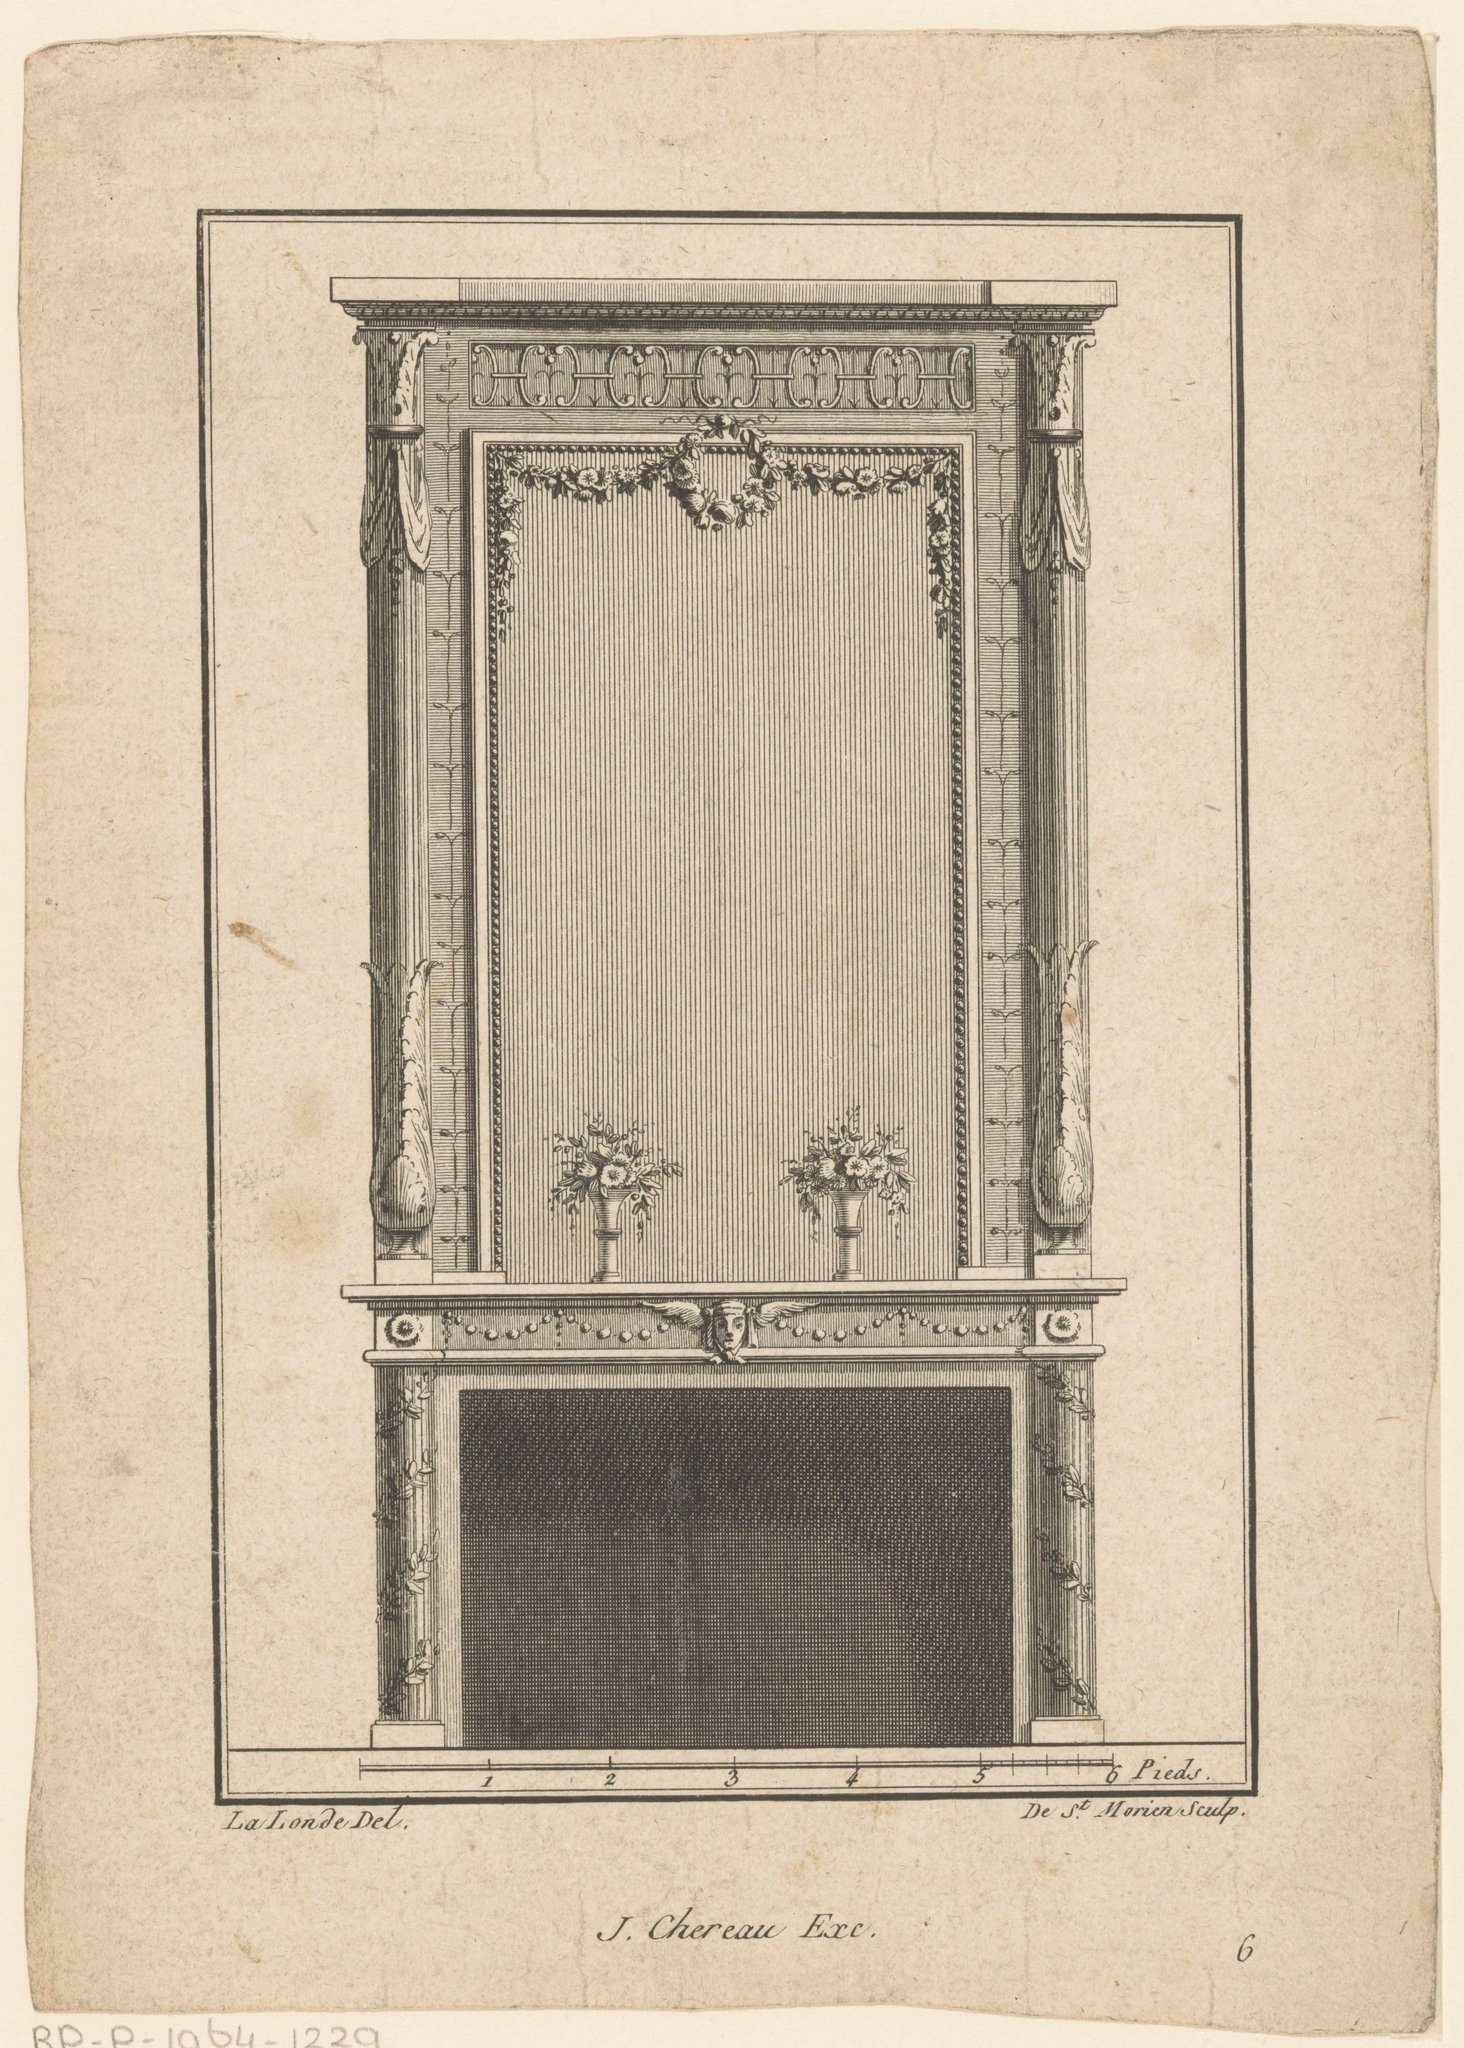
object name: ornament print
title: Schouw met vazen en zuilen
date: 1784-1785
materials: paper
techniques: etching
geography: paris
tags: column, pillar ~ architecture, vase ~ ornament, open hearth, fire-place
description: Een geornamenteerde schouw met vazen met bloemen, guirlandes en zuilen met bladmotieven en guirlandes.